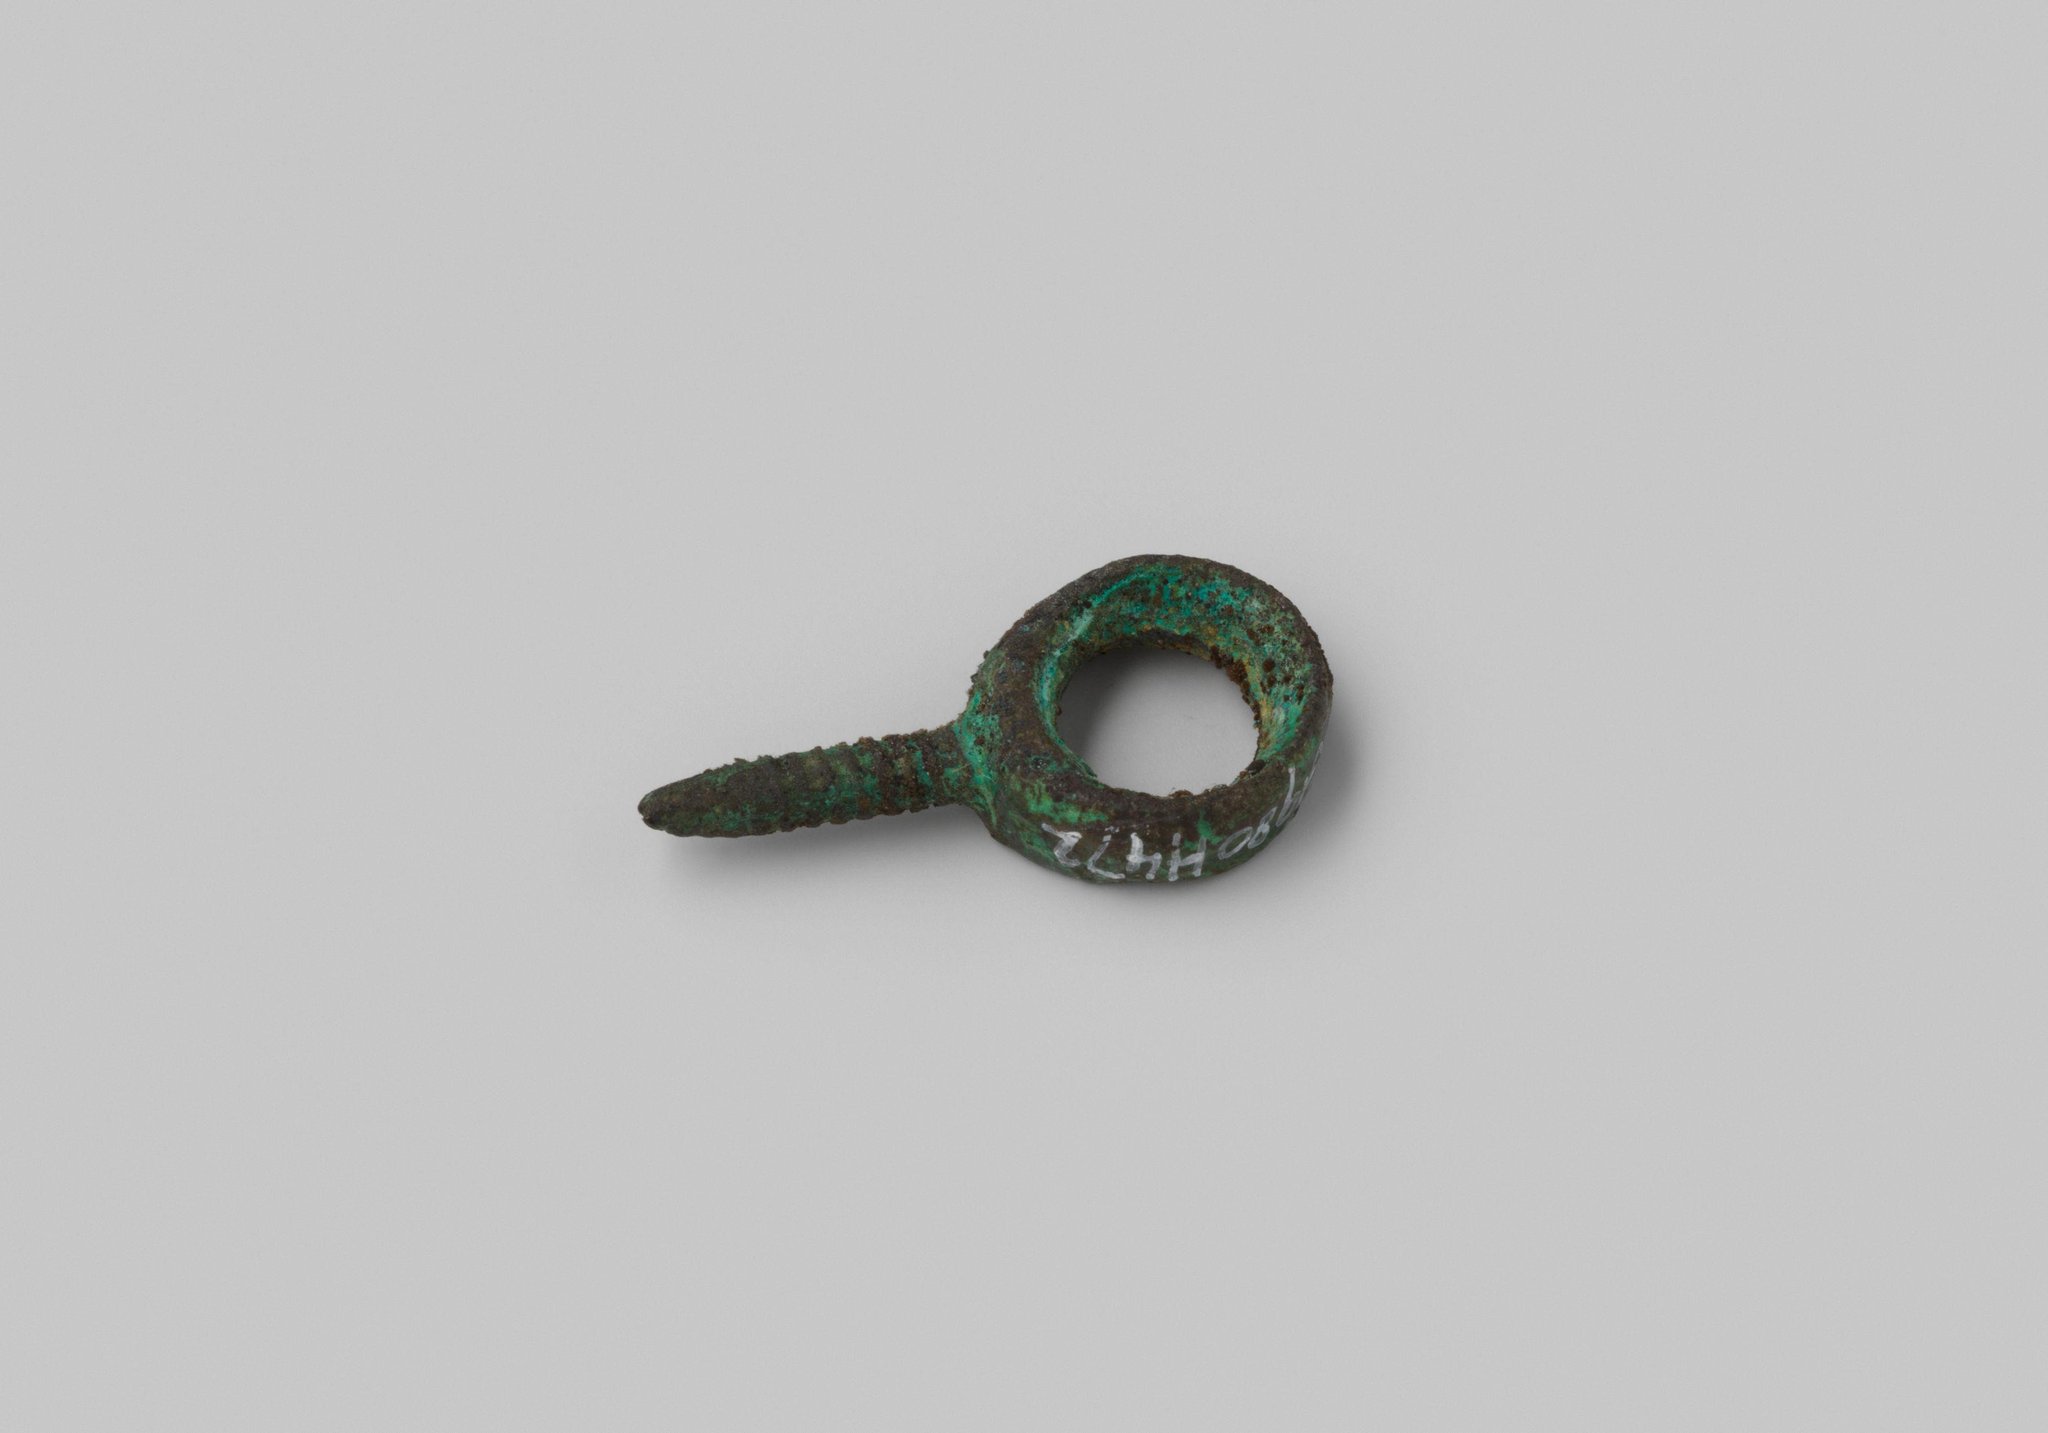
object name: screw eye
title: Schroefoog afkomstig uit het wrak van de Oost-Indiëvaarder Hollandia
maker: Anonymous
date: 1700-1743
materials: copper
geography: netherlands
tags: verenigde oostindische compagnie, hollandia (schip)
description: Screw eyes; circular eye with threaded shaft.